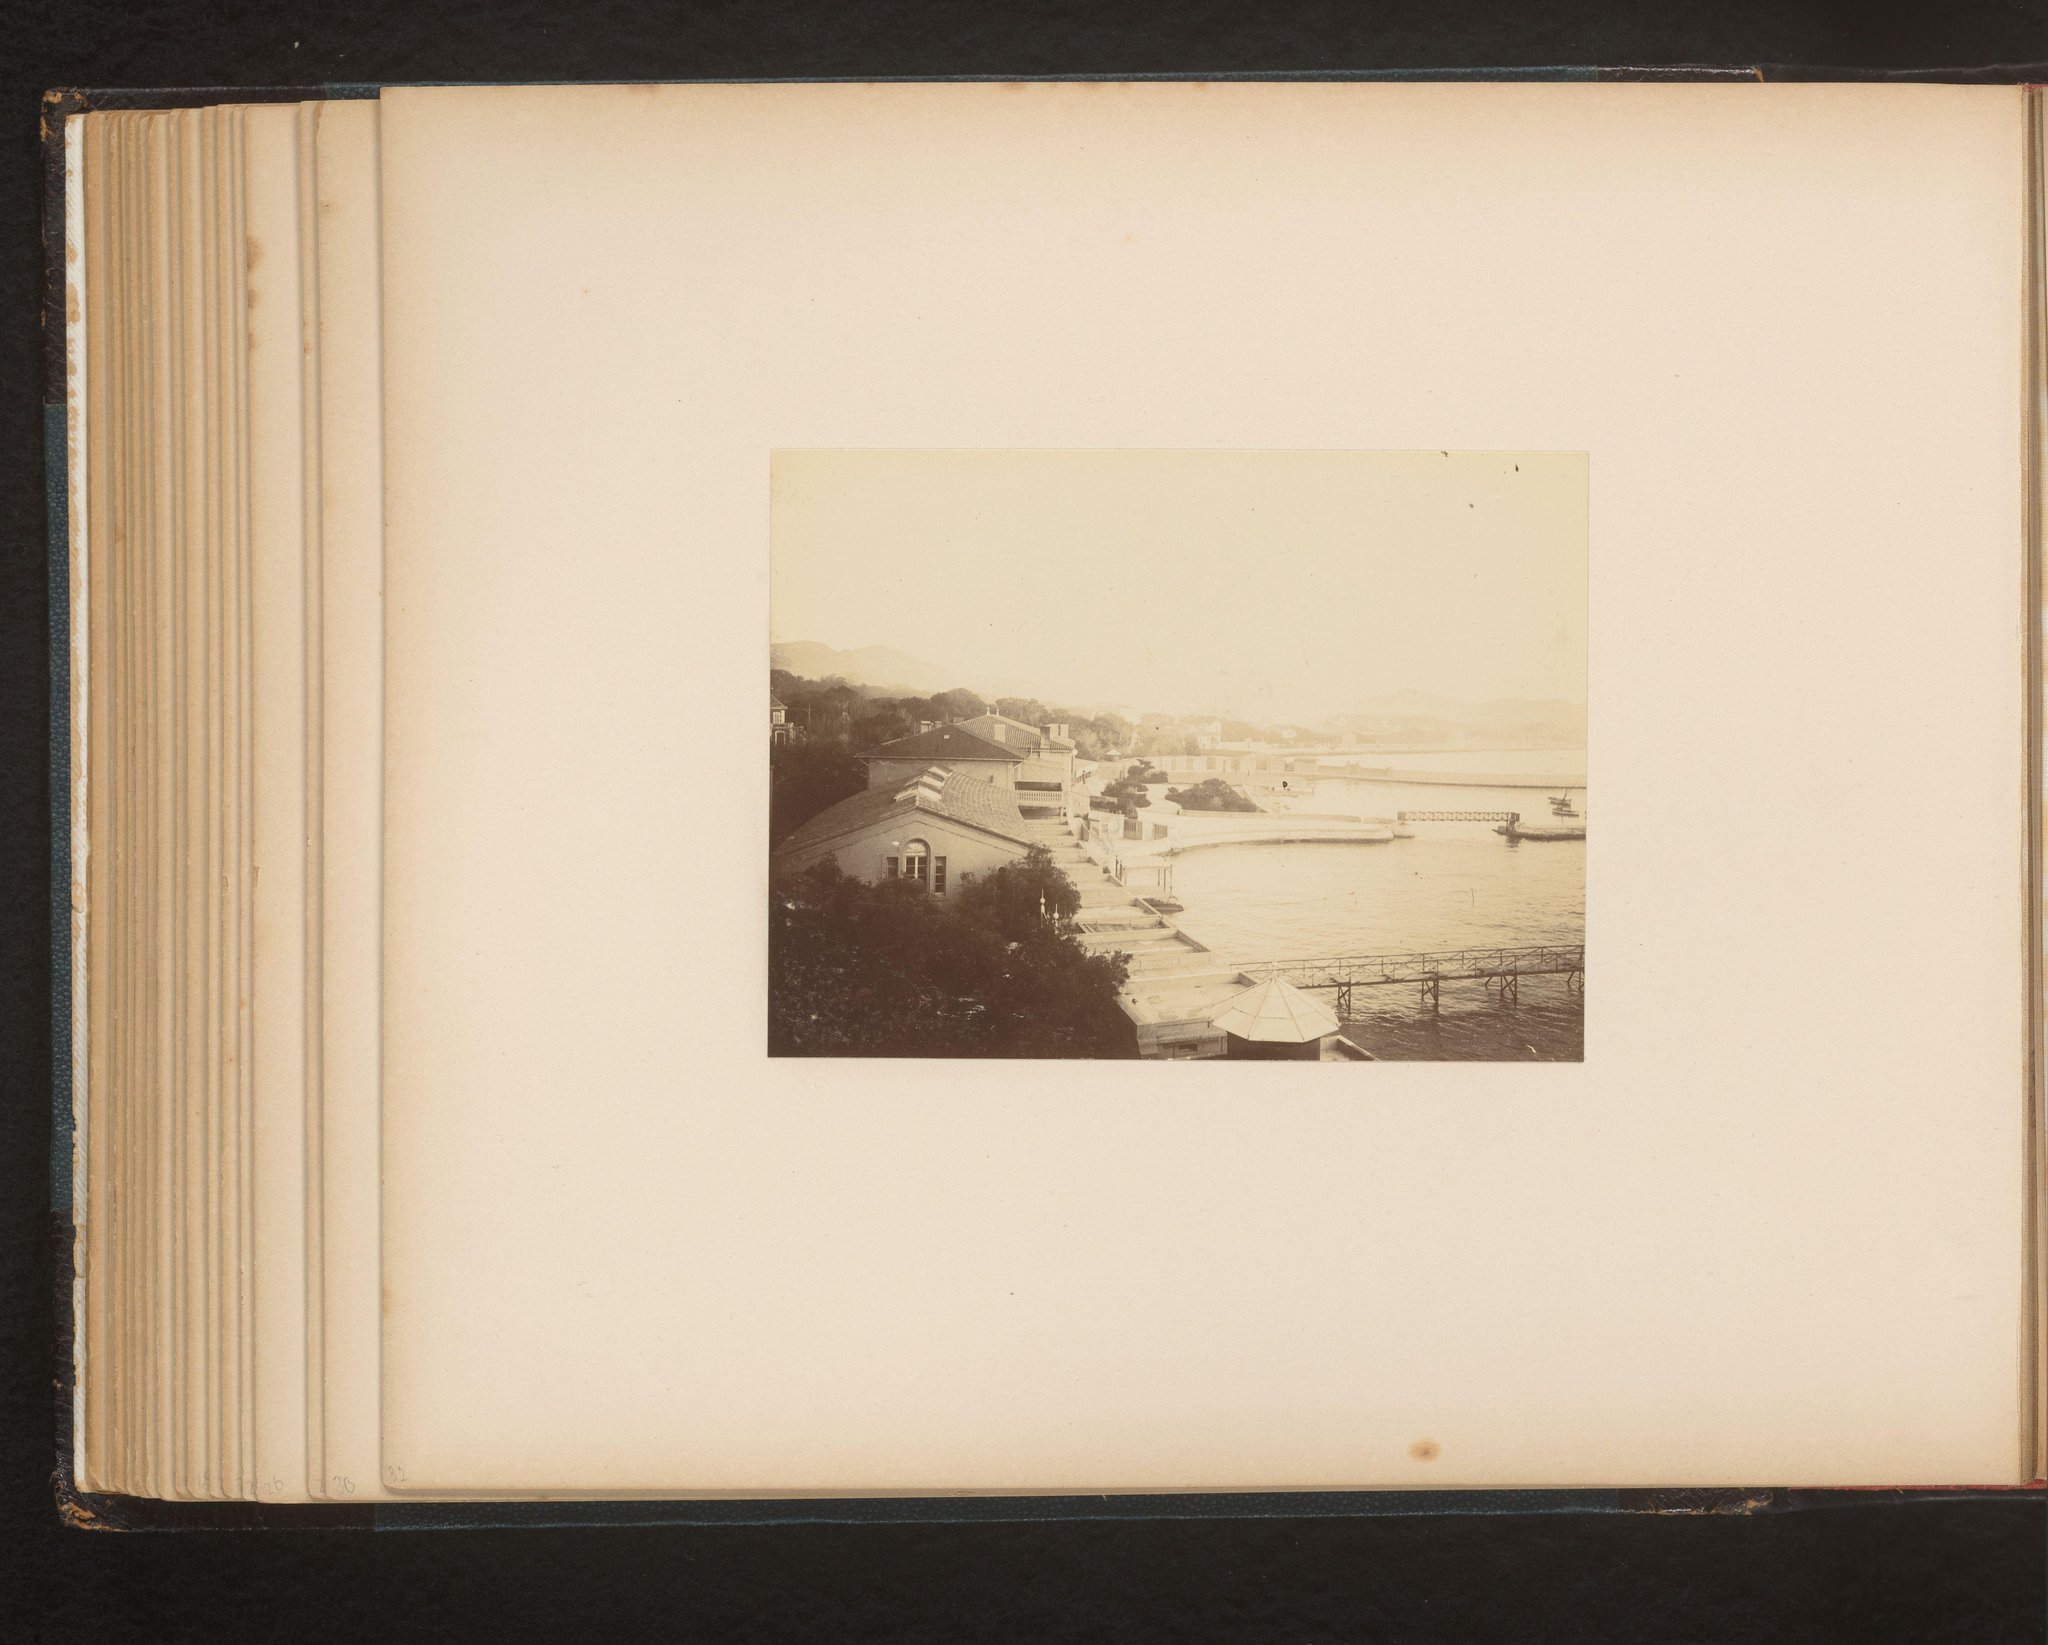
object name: album leaf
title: Gezicht op gebouwen aan de kust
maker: Anonymous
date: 1880-1920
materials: cardboard, photographic support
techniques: gelatin silver print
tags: civic architecture; edifices; dwellings, coast, france